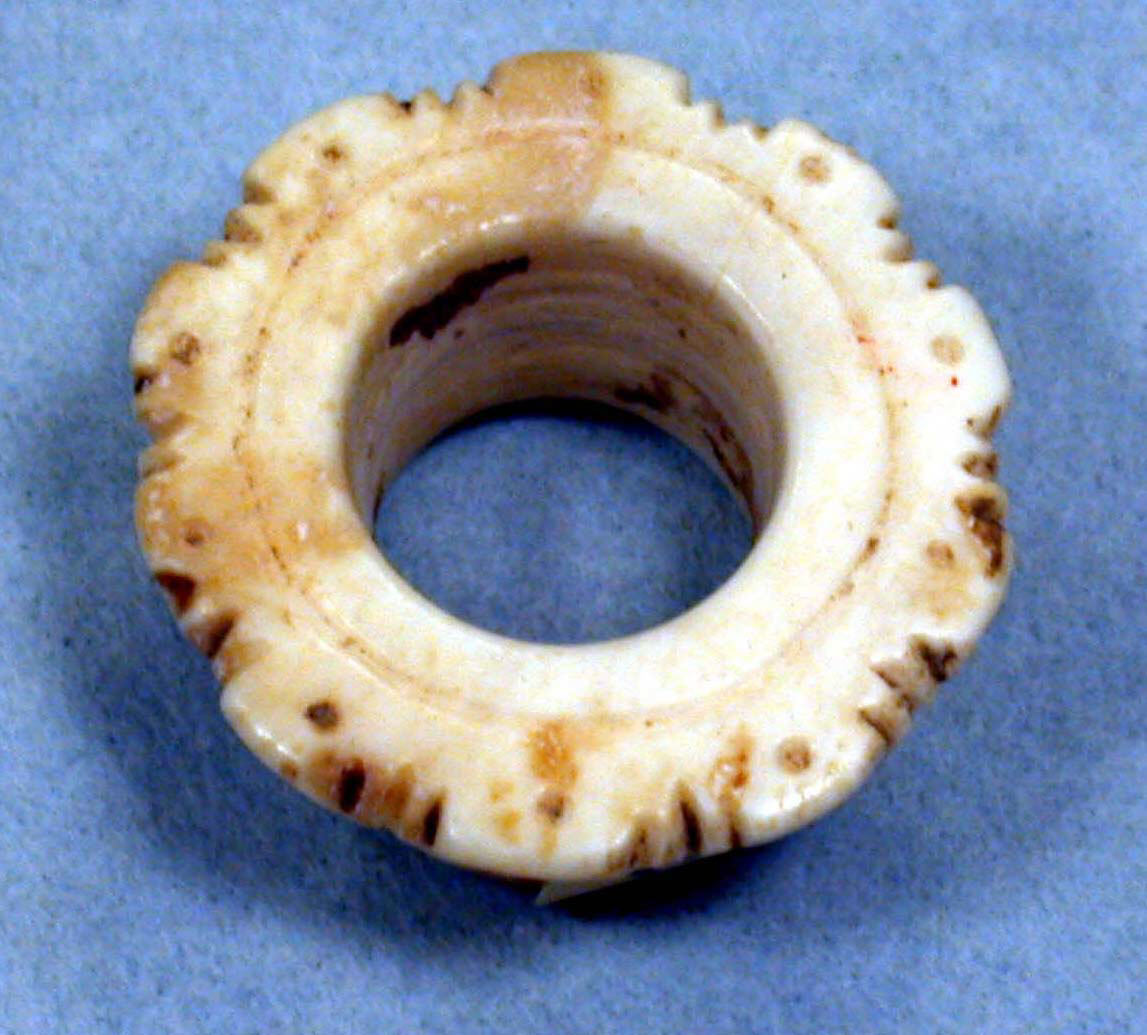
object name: earflare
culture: colima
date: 1501-1600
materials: shell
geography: mexico